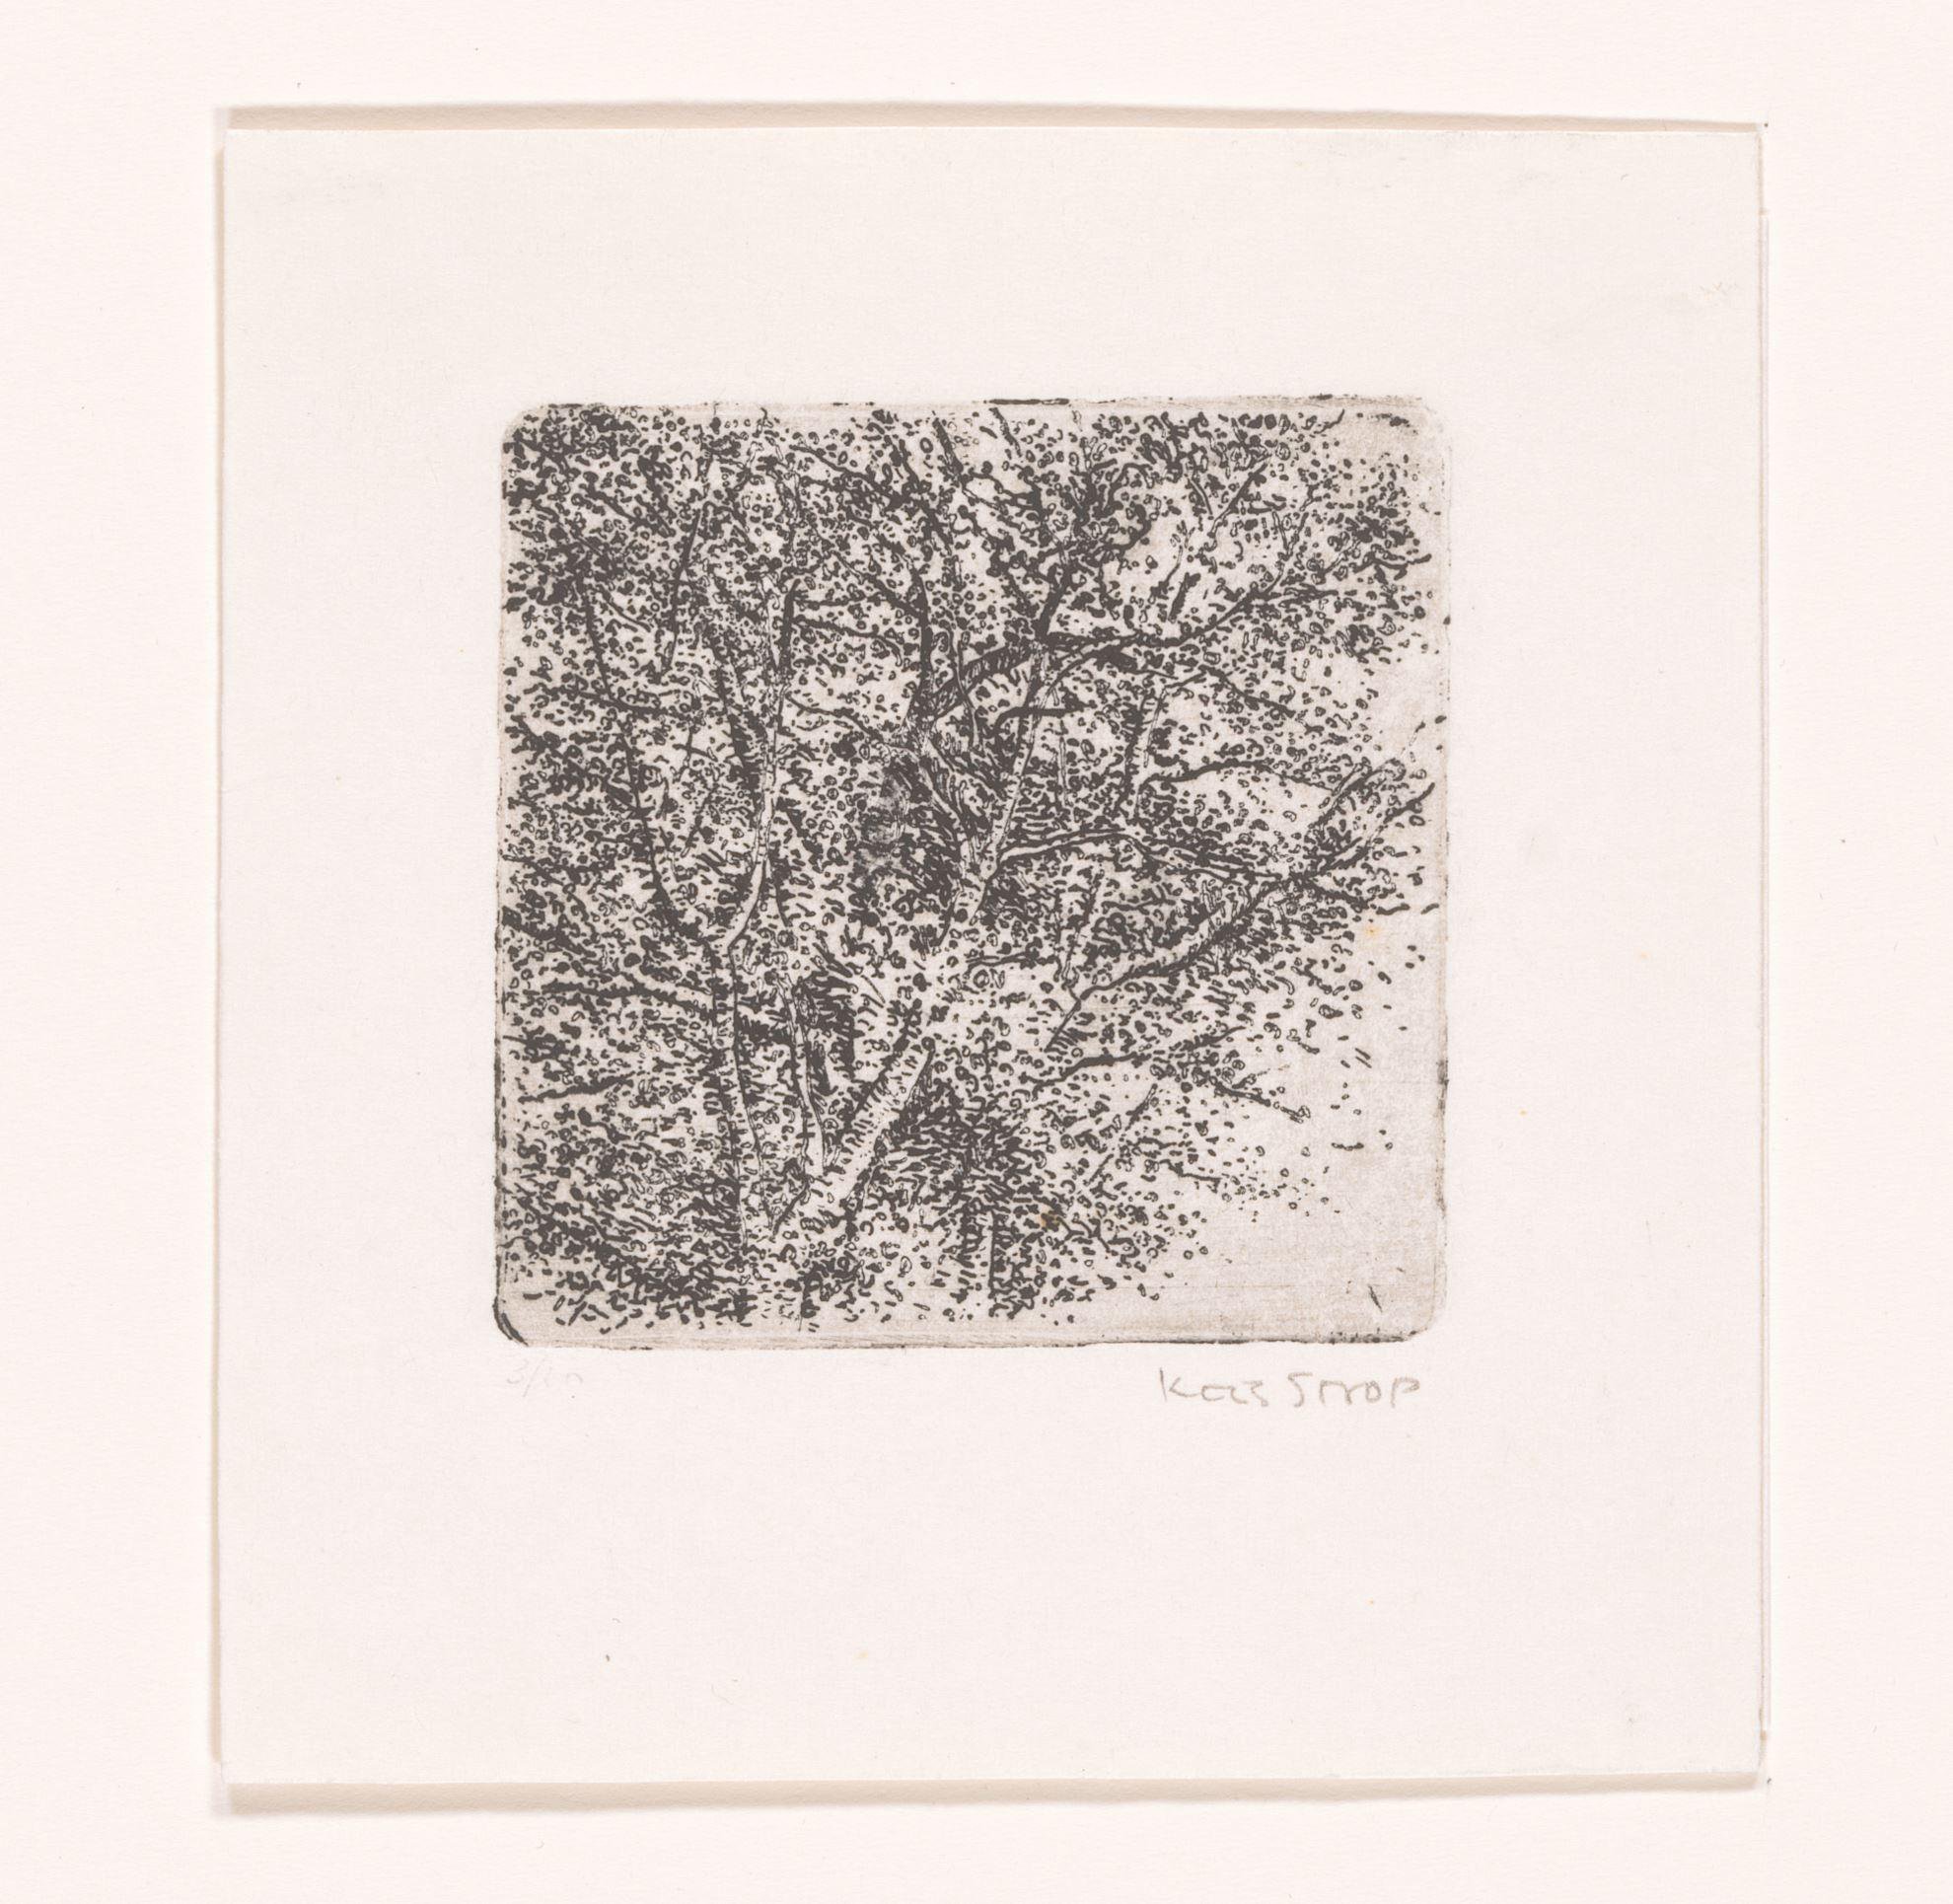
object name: print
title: Boomkruinen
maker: kees stoop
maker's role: draughtsman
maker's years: 1929-2019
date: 1944-1990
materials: paper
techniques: etching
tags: trees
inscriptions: signature: ‘KEES STOOP’